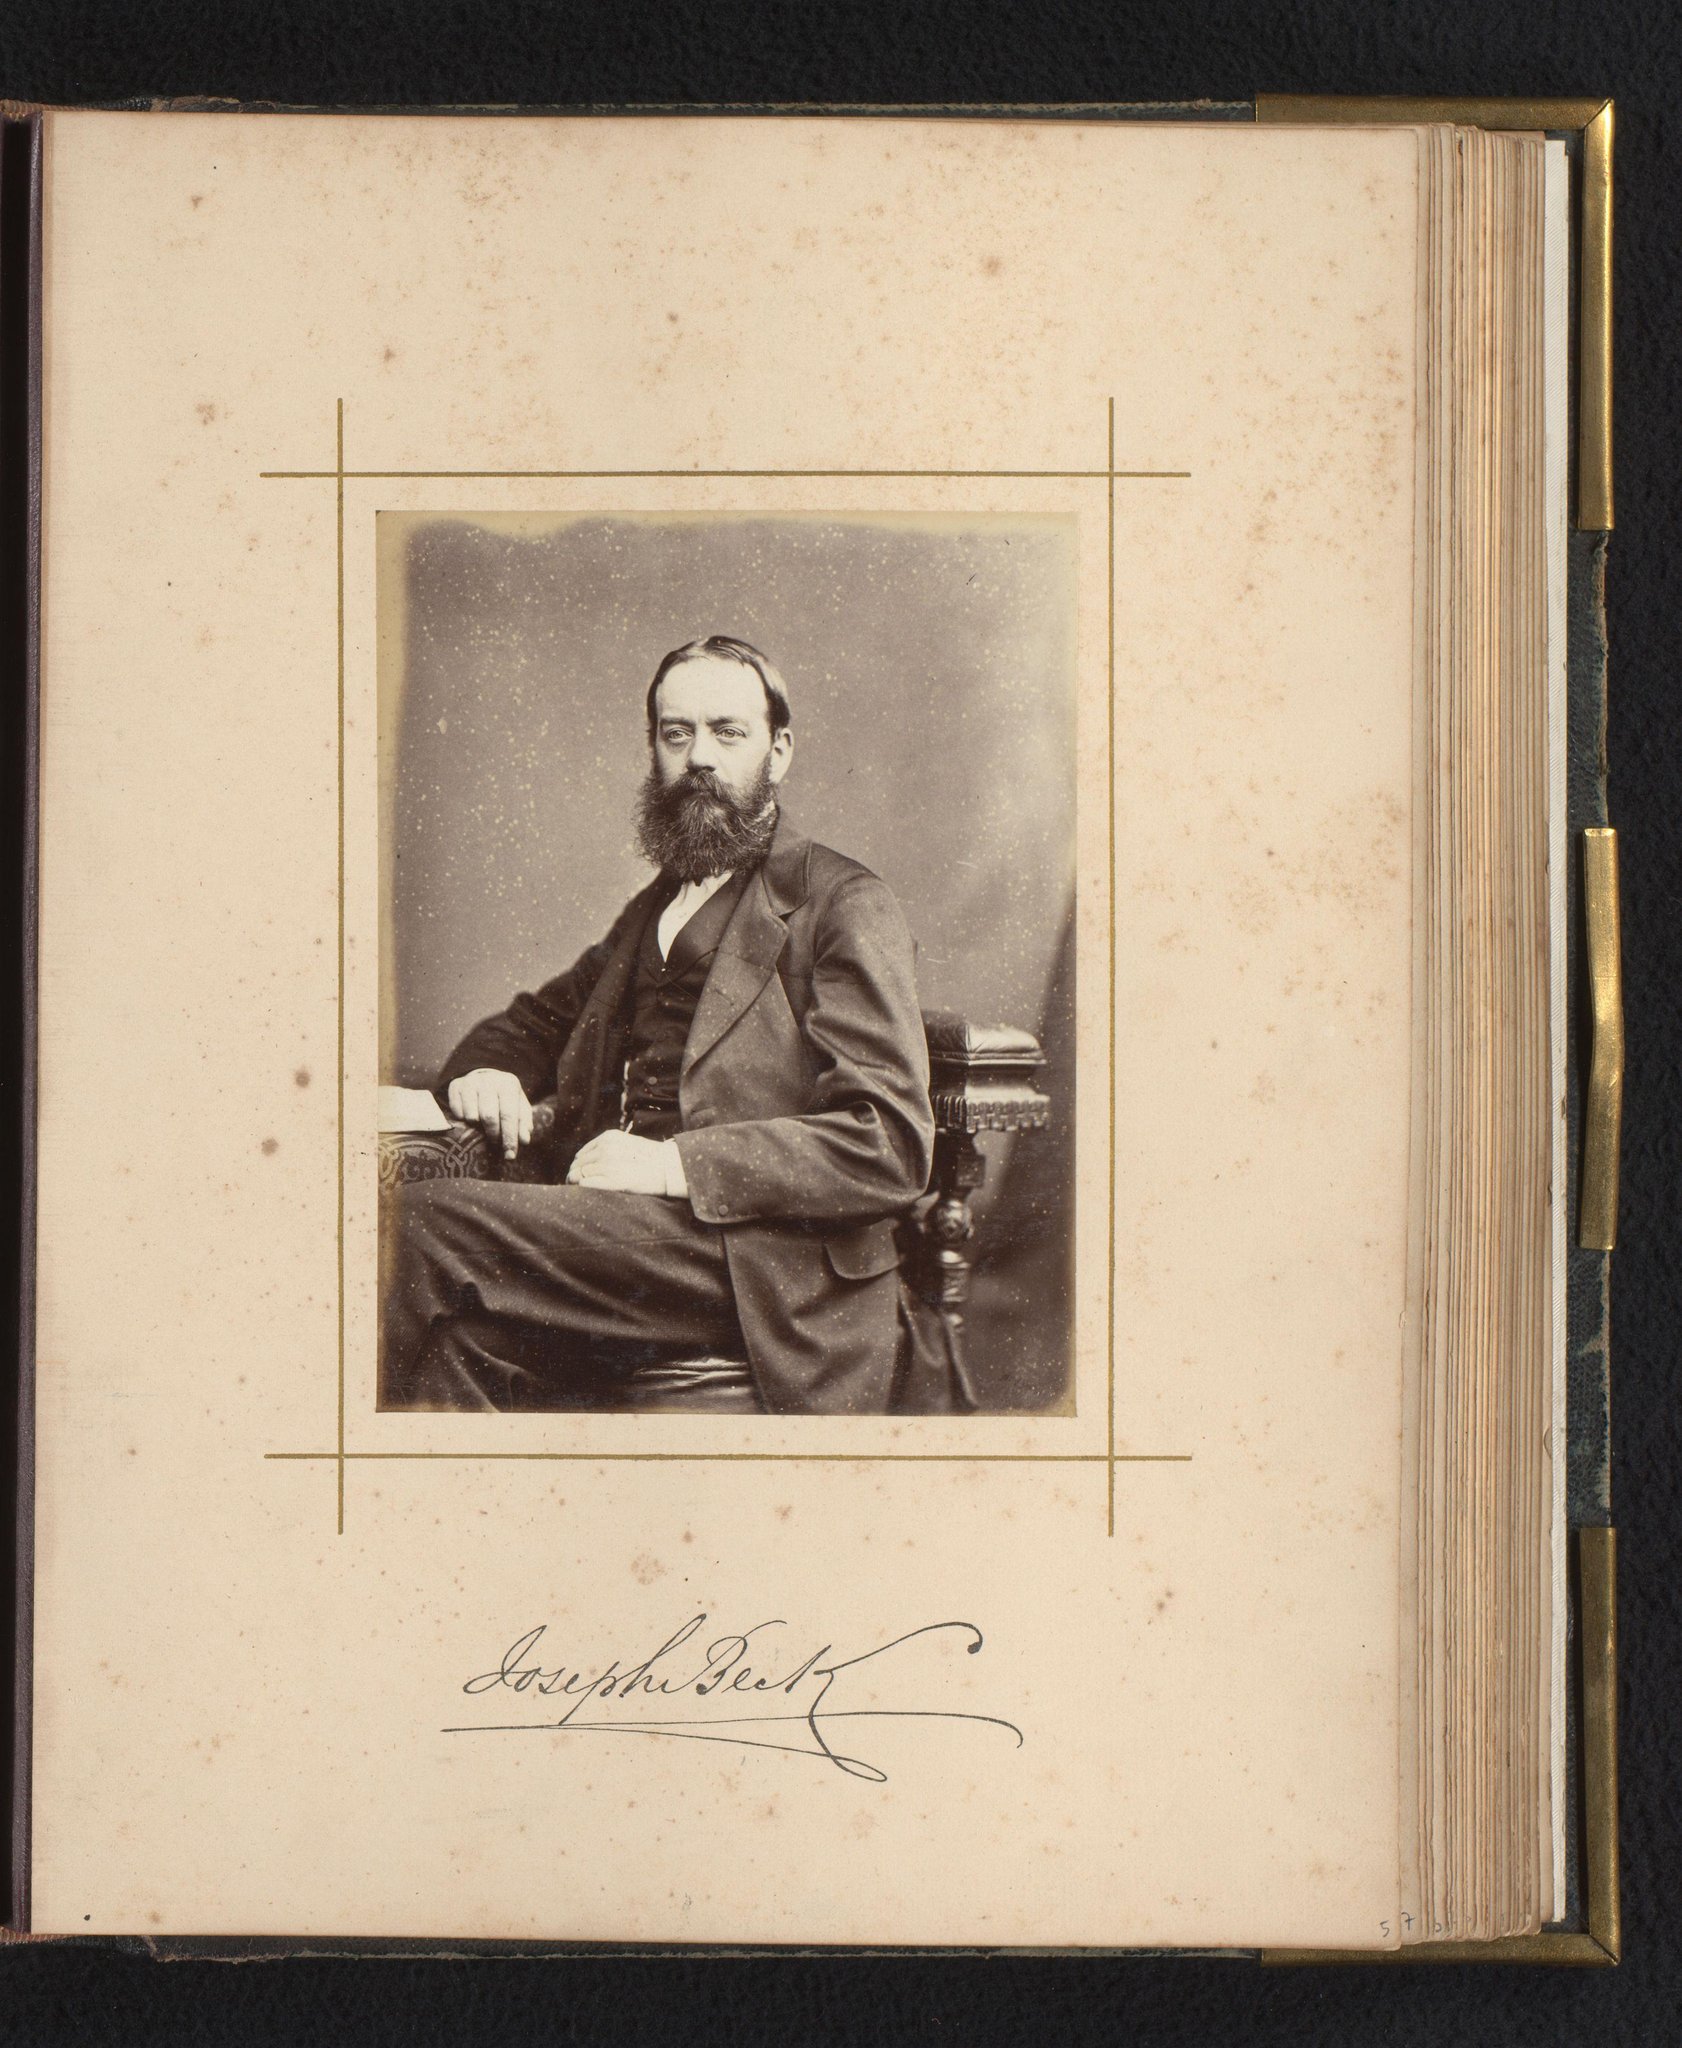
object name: page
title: Portret van Joseph Beck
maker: Anonymous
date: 1866-1871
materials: photographic support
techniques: albumen print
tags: historical persons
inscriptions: name: ‘Joseph Beck’